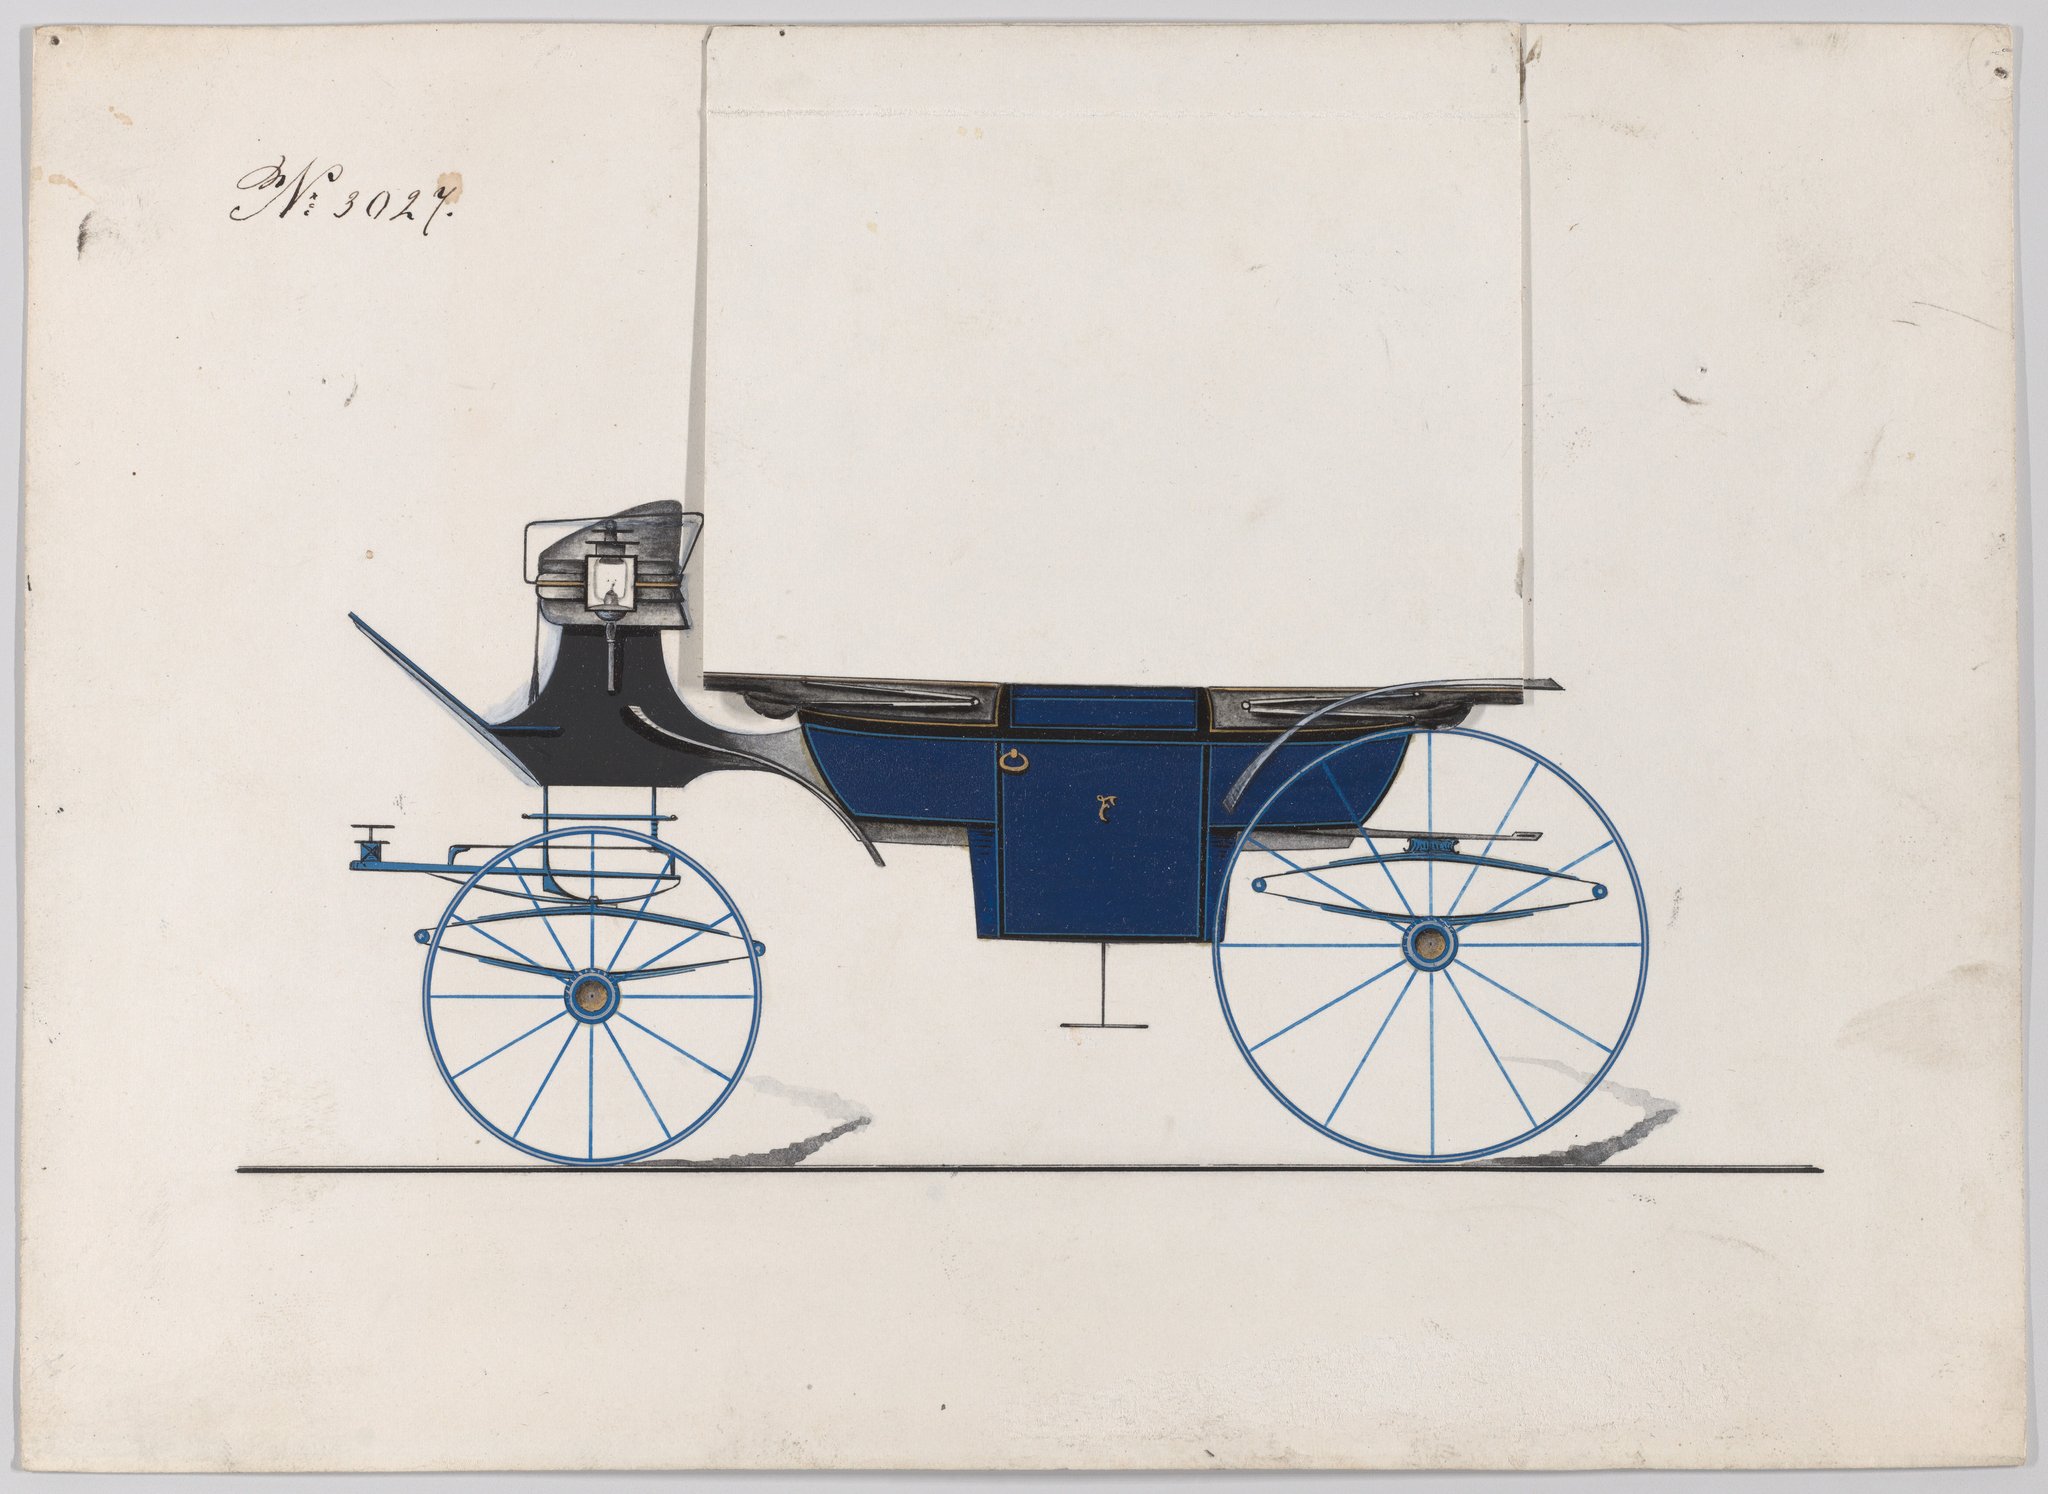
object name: drawing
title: Design for Landau, No. 3027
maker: brewster & co.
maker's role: manufacturer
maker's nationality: american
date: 1874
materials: gouache, gum arabic, ink, watercolor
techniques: pen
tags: carriages